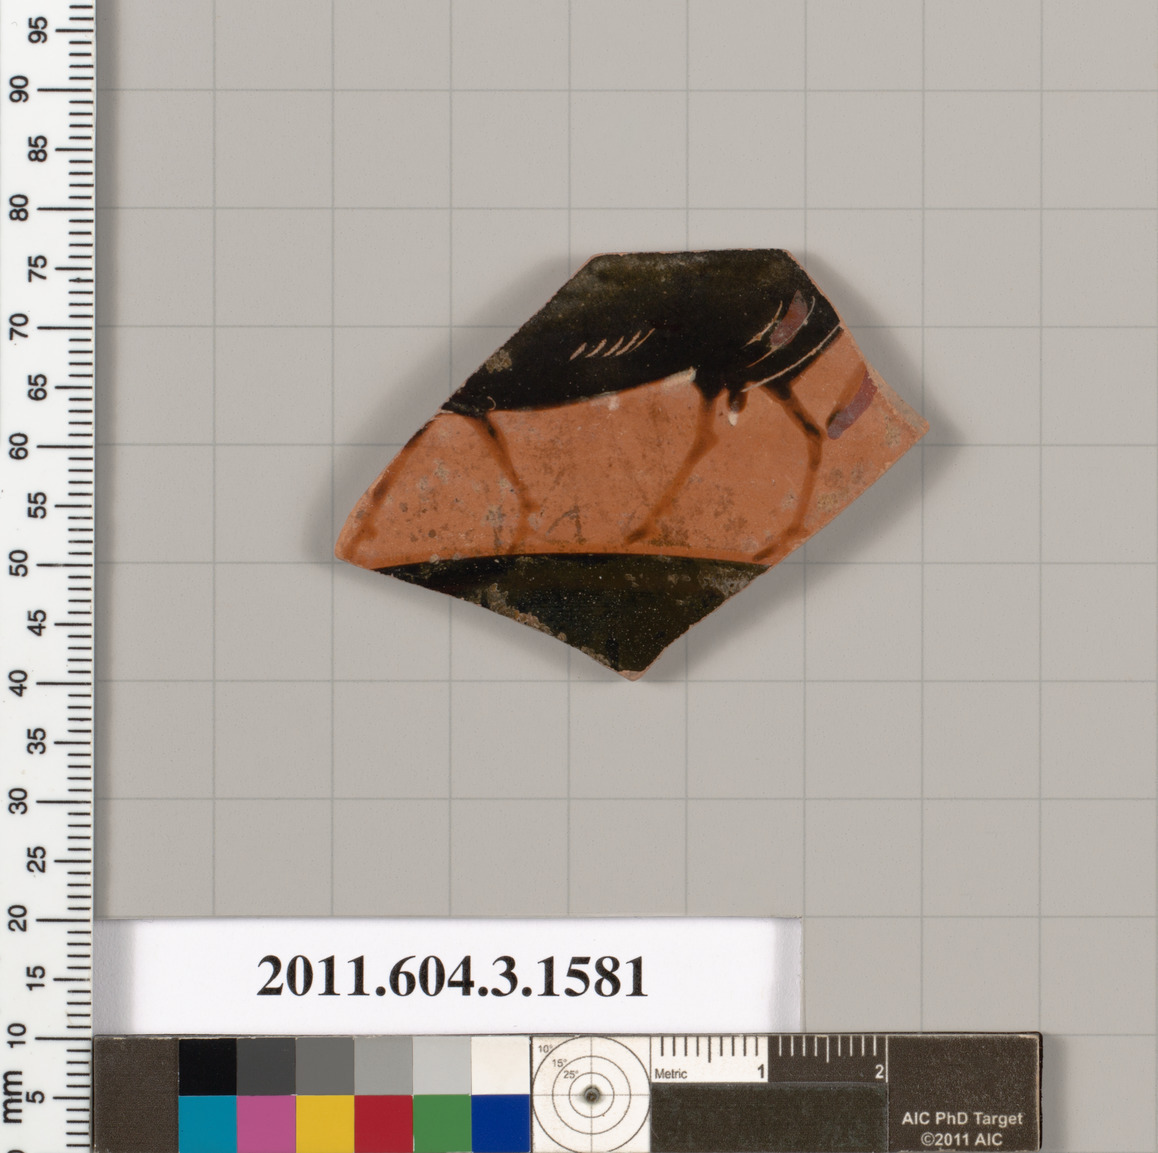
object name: kylix fragment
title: Terracotta fragment of a kylix: Band cup (drinking cup)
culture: greek, attic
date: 550-526 BCE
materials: terracotta